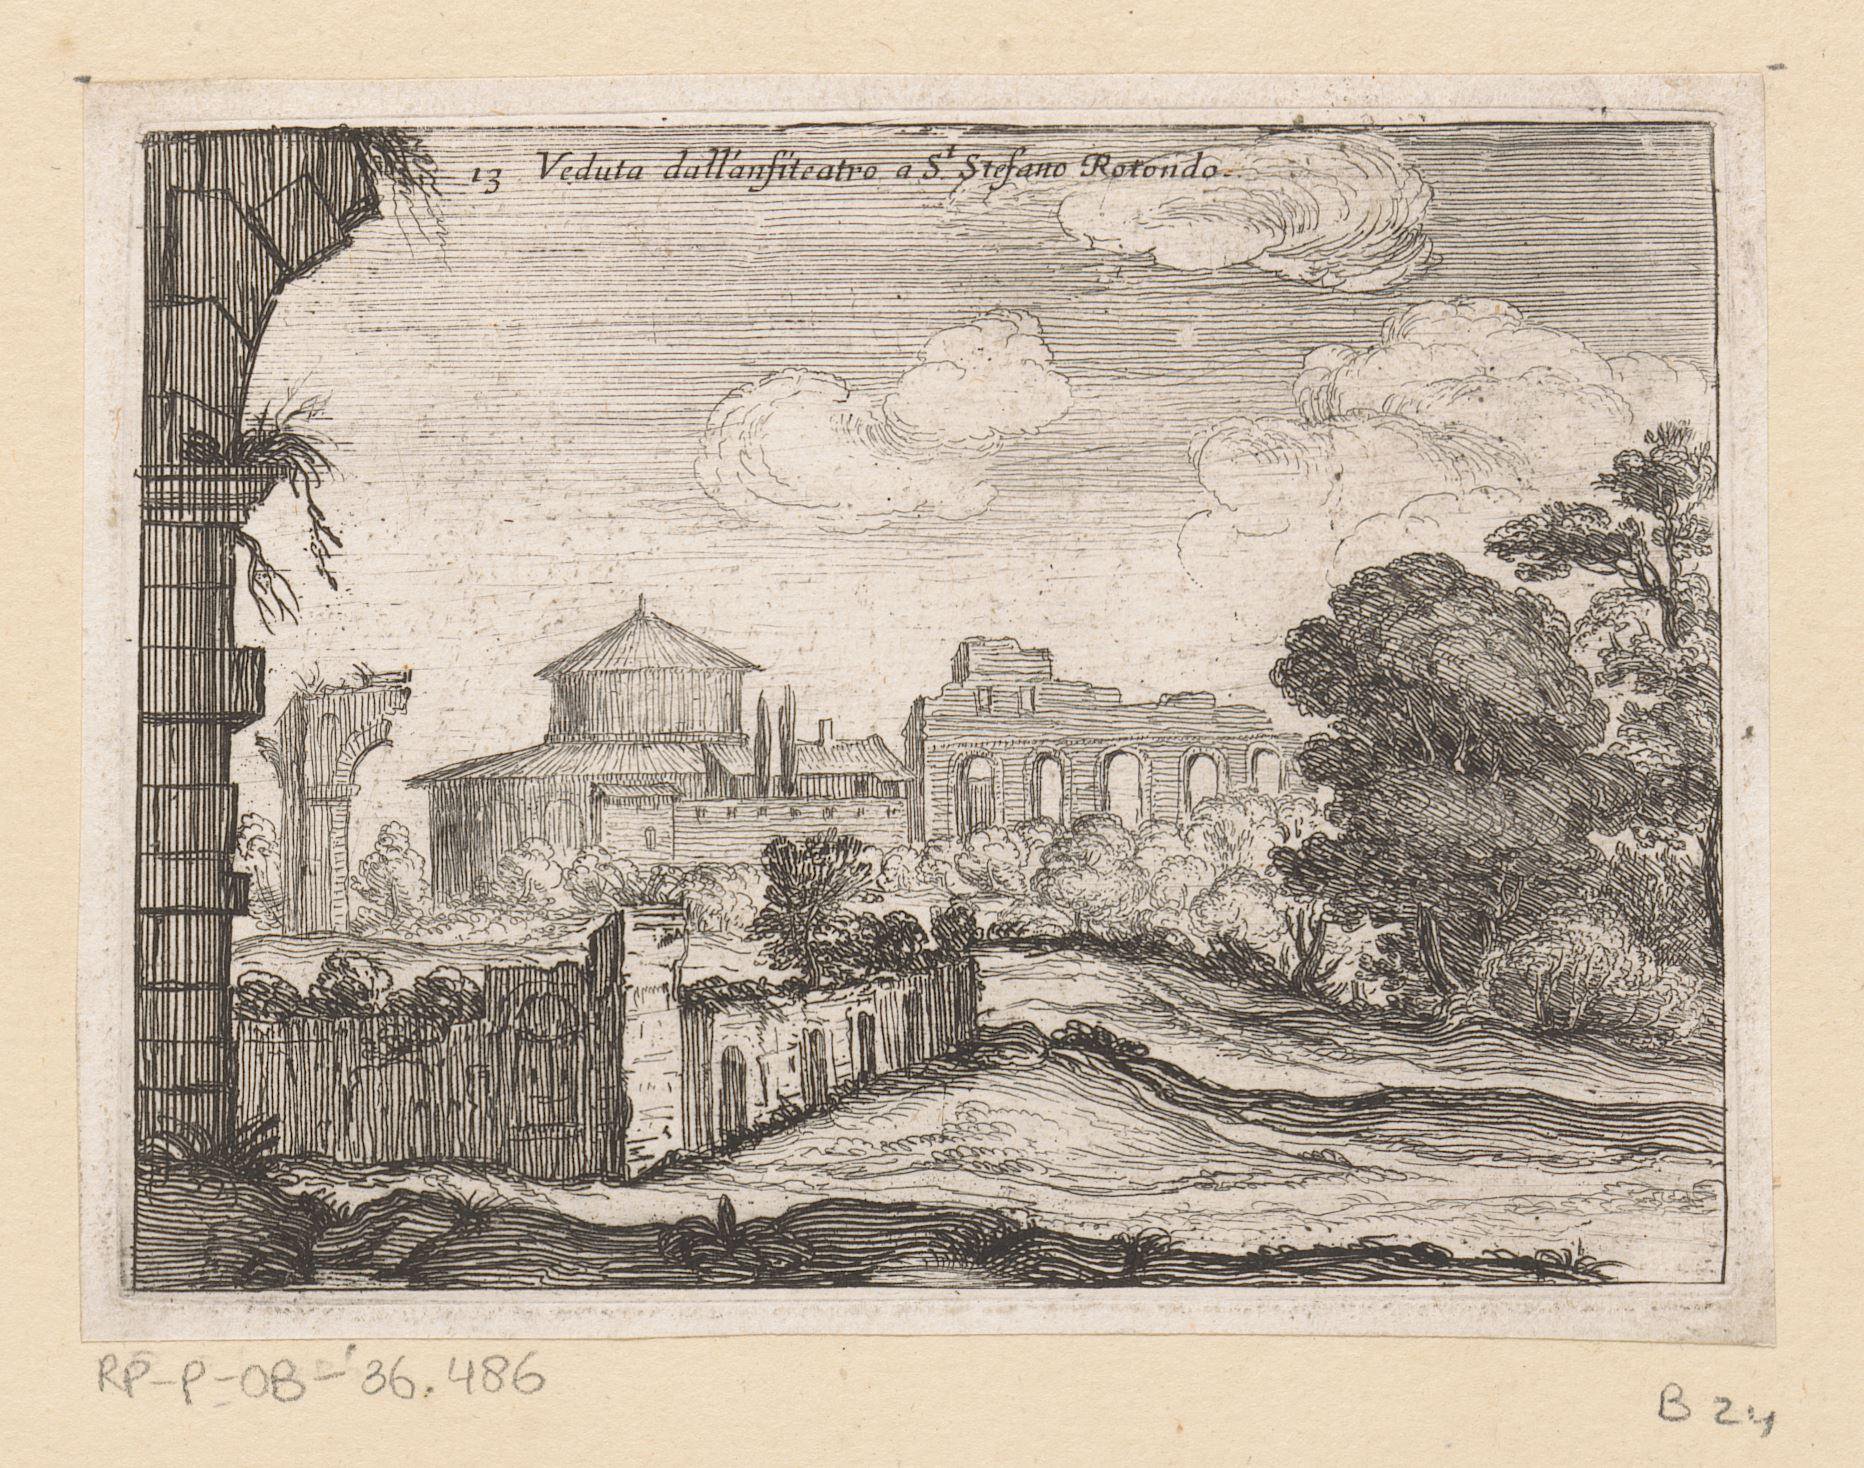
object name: print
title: Gezichten op Rome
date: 1629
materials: paper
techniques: etching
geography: italy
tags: landscape with ruins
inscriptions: collector's mark: Lugt 2228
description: Deze prent maakt deel uit van een reeks van 52 prenten.